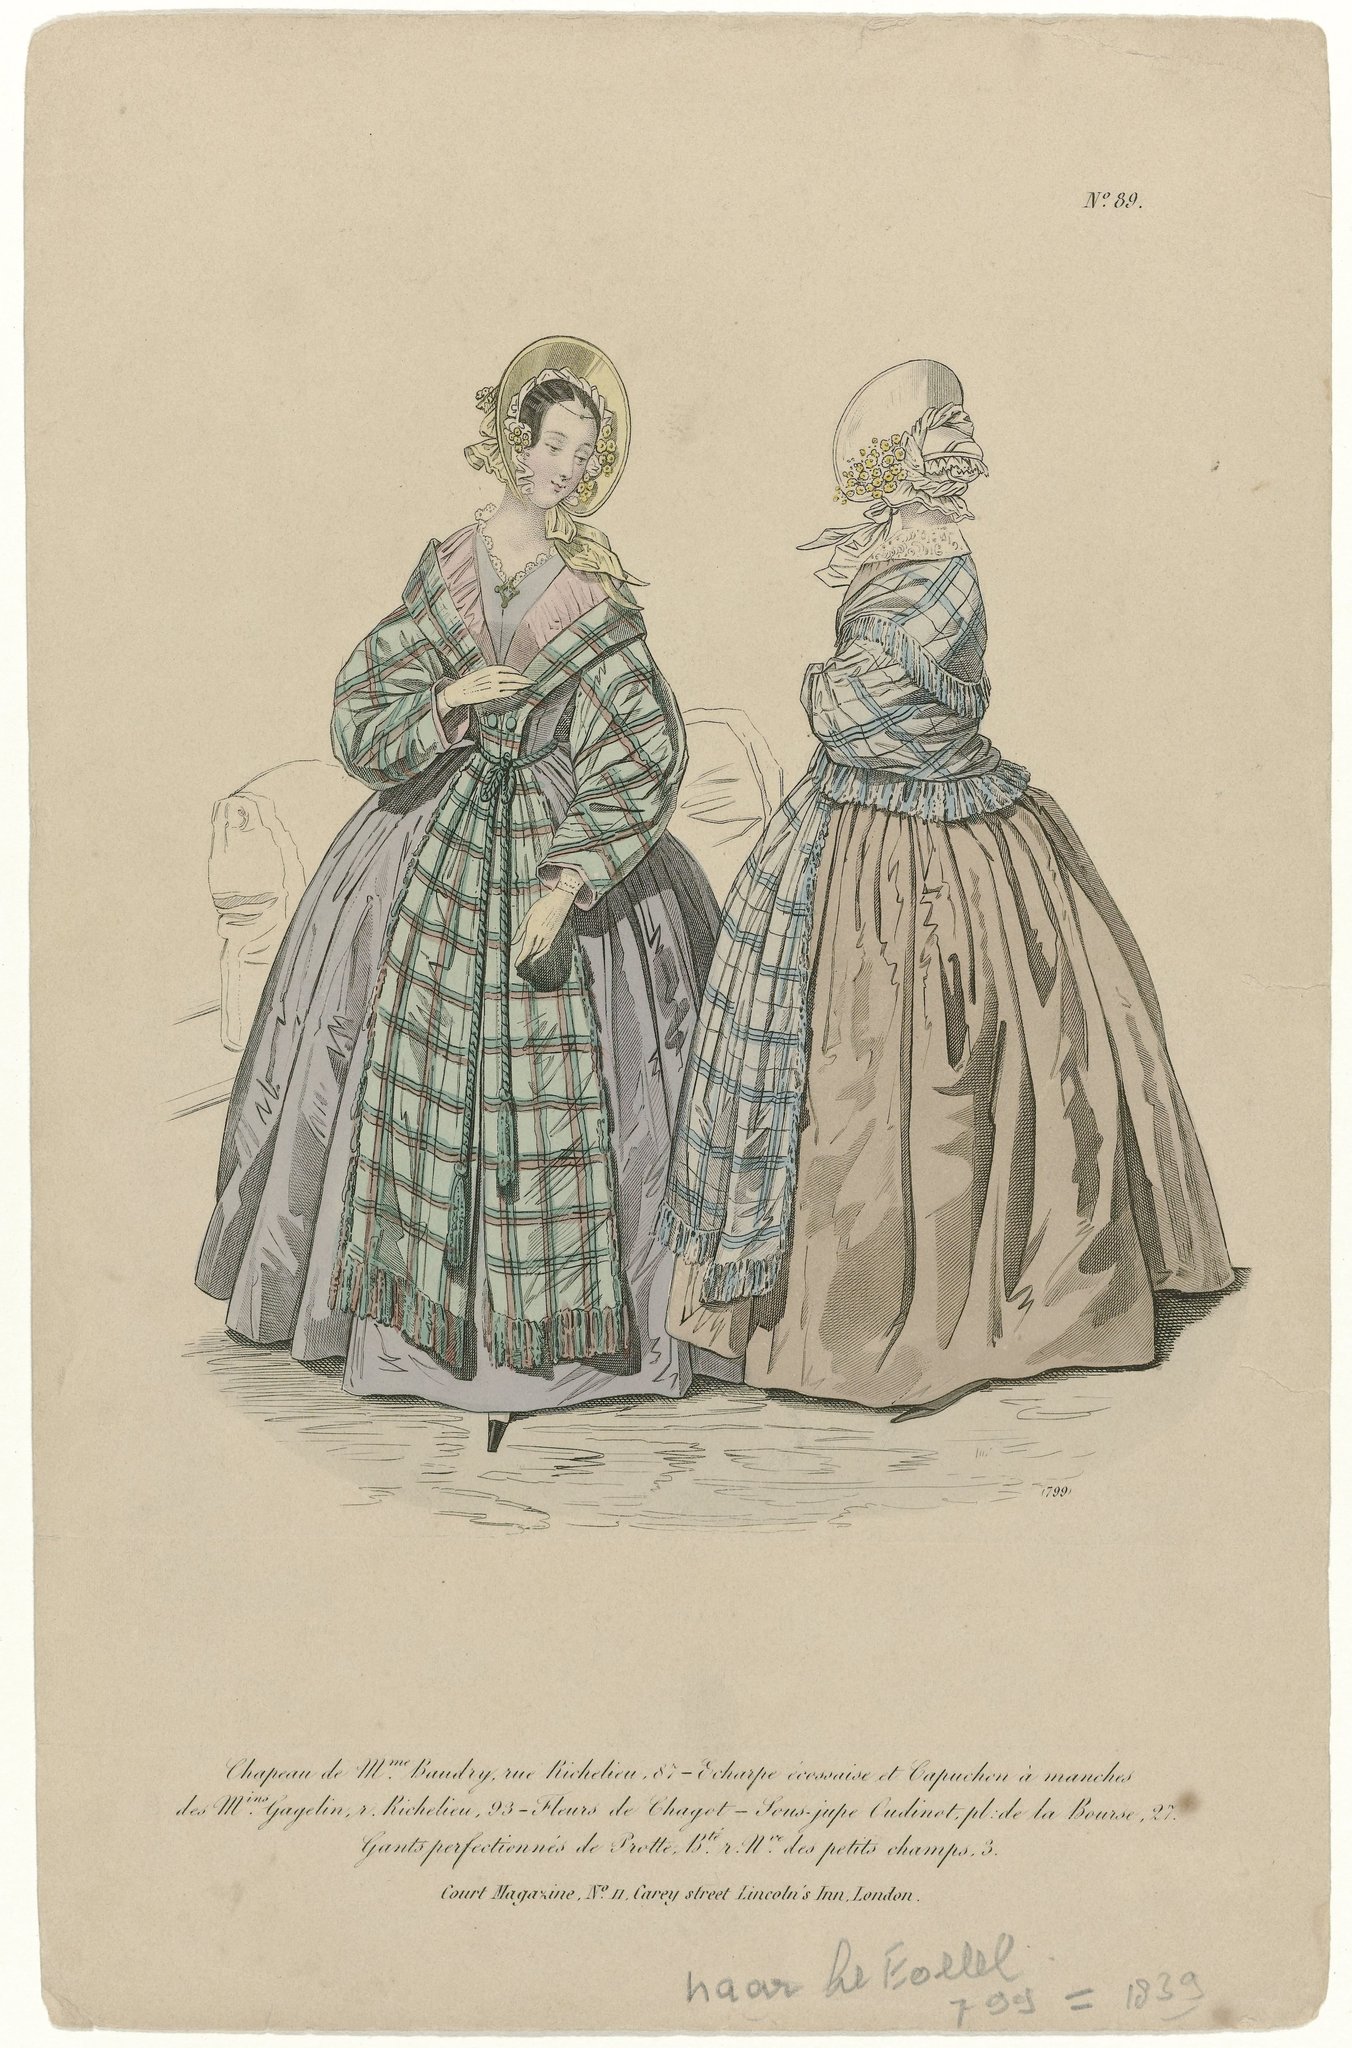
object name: fashion print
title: Court Magazine, 1839, No. 89 : Chapeau de Mme Baudry (...)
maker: Anonymous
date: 1839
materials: paper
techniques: engraving, hand coloring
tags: flowers, brooch, agraffe, clasp (+ women's clothes), diadem, tiara (+ women's clothes), clothing for the upper part of the body (shawl) (+ women's clothes), head-gear: hood (+ women's clothes), fashion plates, skirt (+ women's clothes), gloves, mittens, etc. (+ women's clothes), dress, gown (+ women's clothes)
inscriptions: caption: ‘Chapeau de M.me Baudry, rue Richelieu, 87 - Echarpe écossaise et Capuchon à manches des M.ins Gagelin, r. Richlieu, 93- Fleurs de Chagot- Sous-jupe Oudinot, pl: de la Bourse, 27. Gants perfectionnés de Protte, B.té r. N.ve des petits champs, 3.’, address: ‘Court Magazine, No. 11 Carey street Lincoln's Inn. London.’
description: Hoed van Baudry. Schots geruite sjaal met capuchon en mouwen uit de winkels van Gagelin. Bloemen van Chagot. Onderrok of 'sous-jupe' van Oudinot. Handschoenen van Protte, gepatenteerd. Prent uit het modetijdschrift Court Magazine (1827-1842).